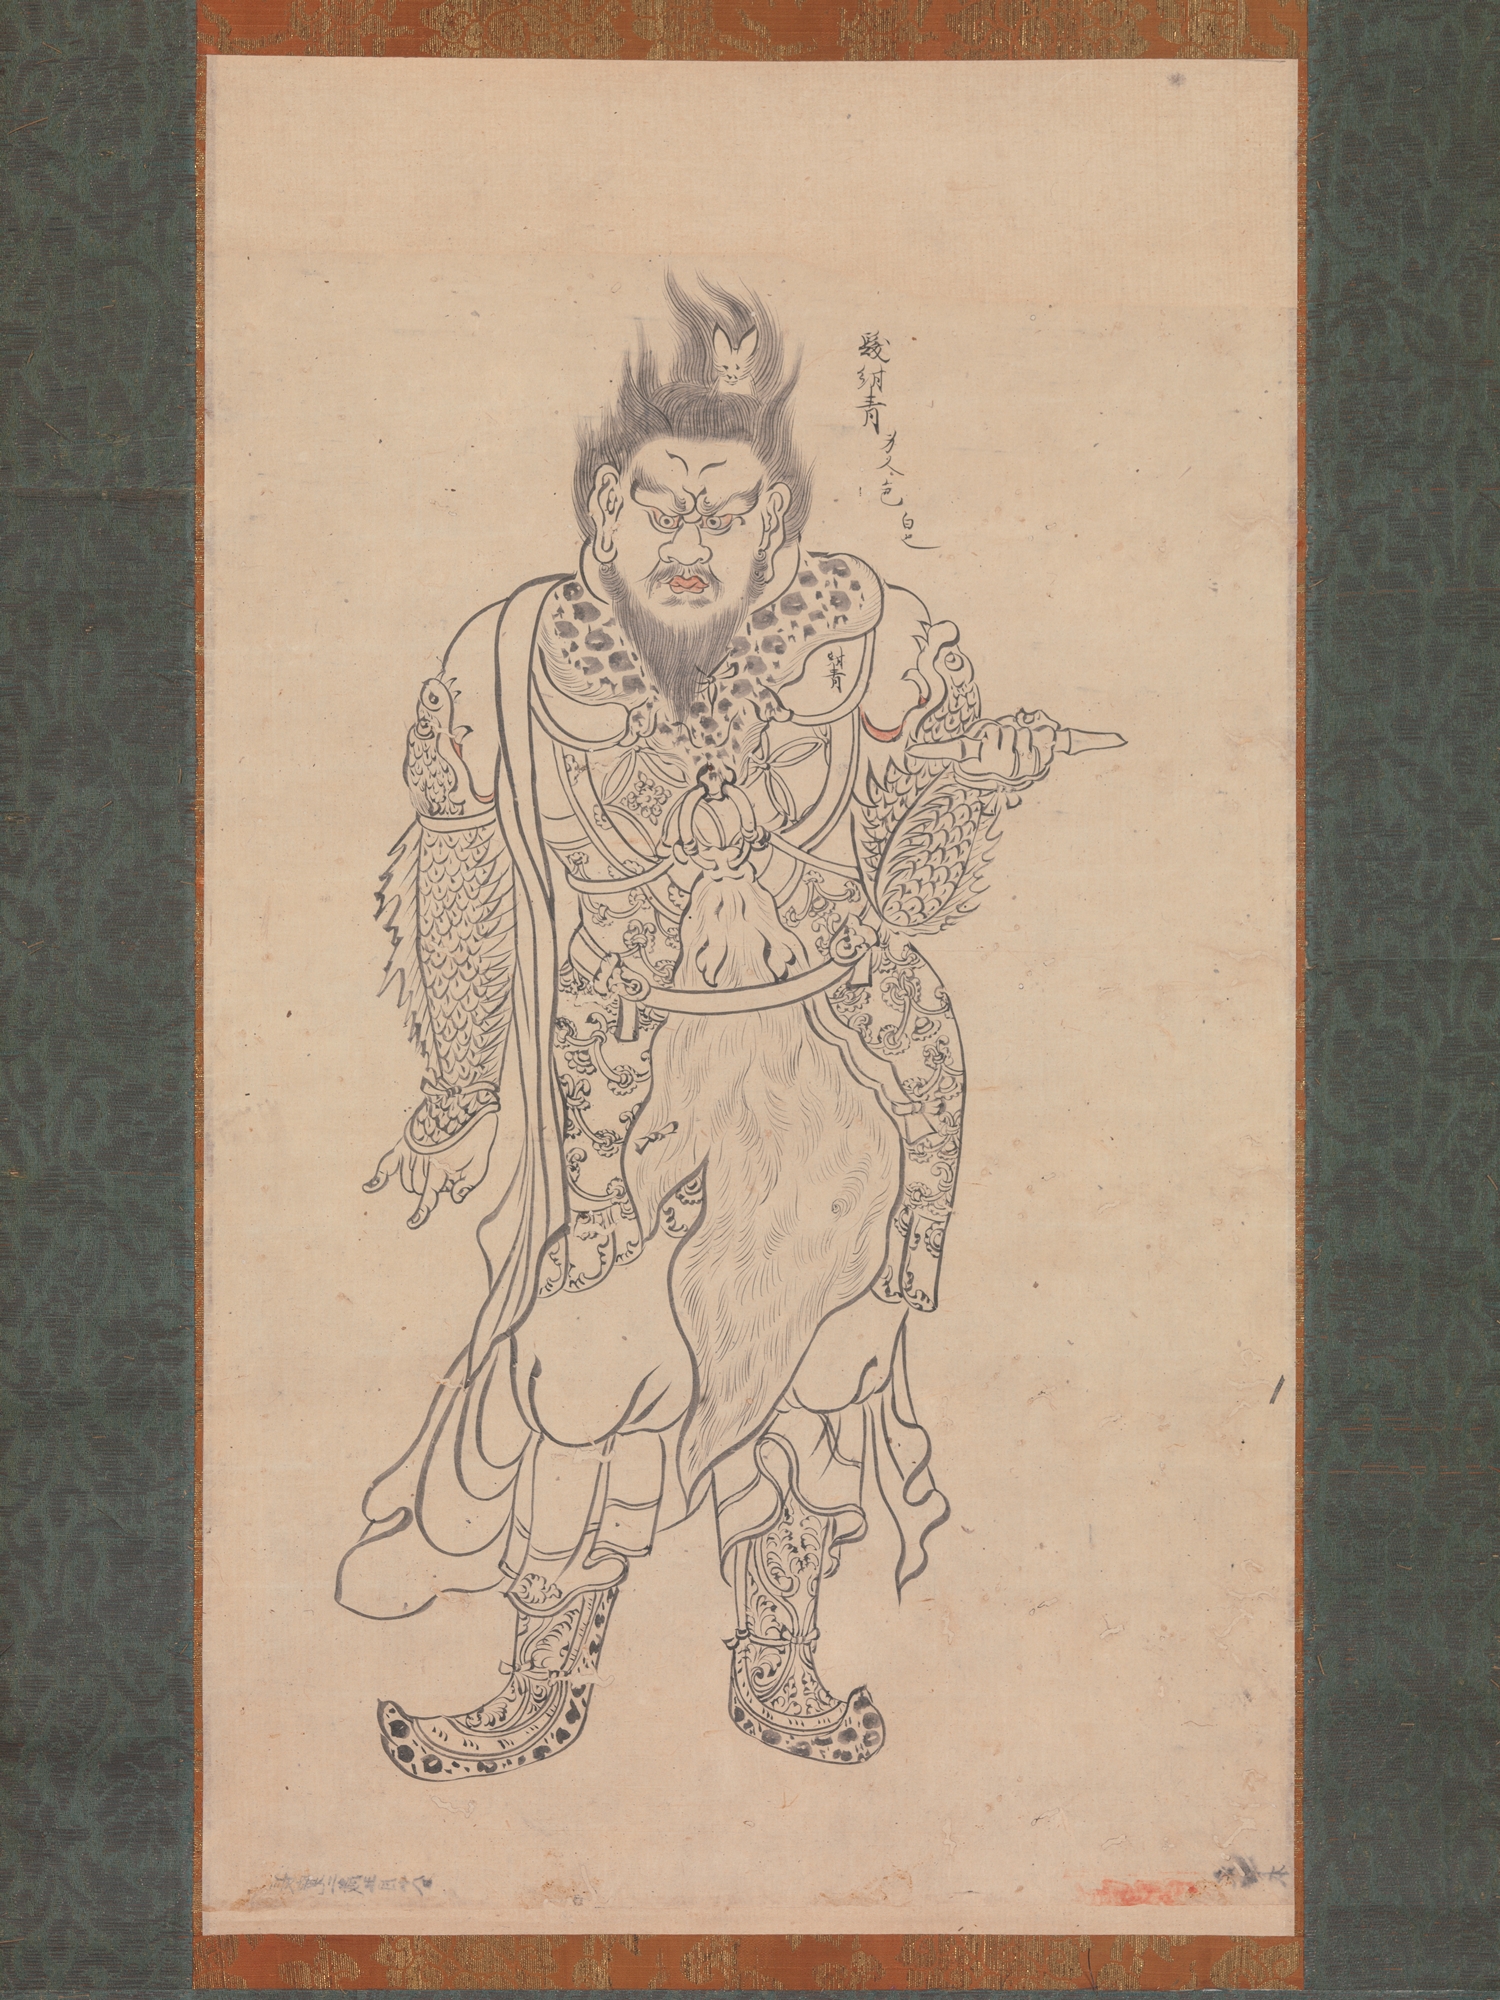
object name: hanging scroll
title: Anchira-taisho Jochi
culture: japanese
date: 1164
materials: ink, paper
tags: men,rabbits